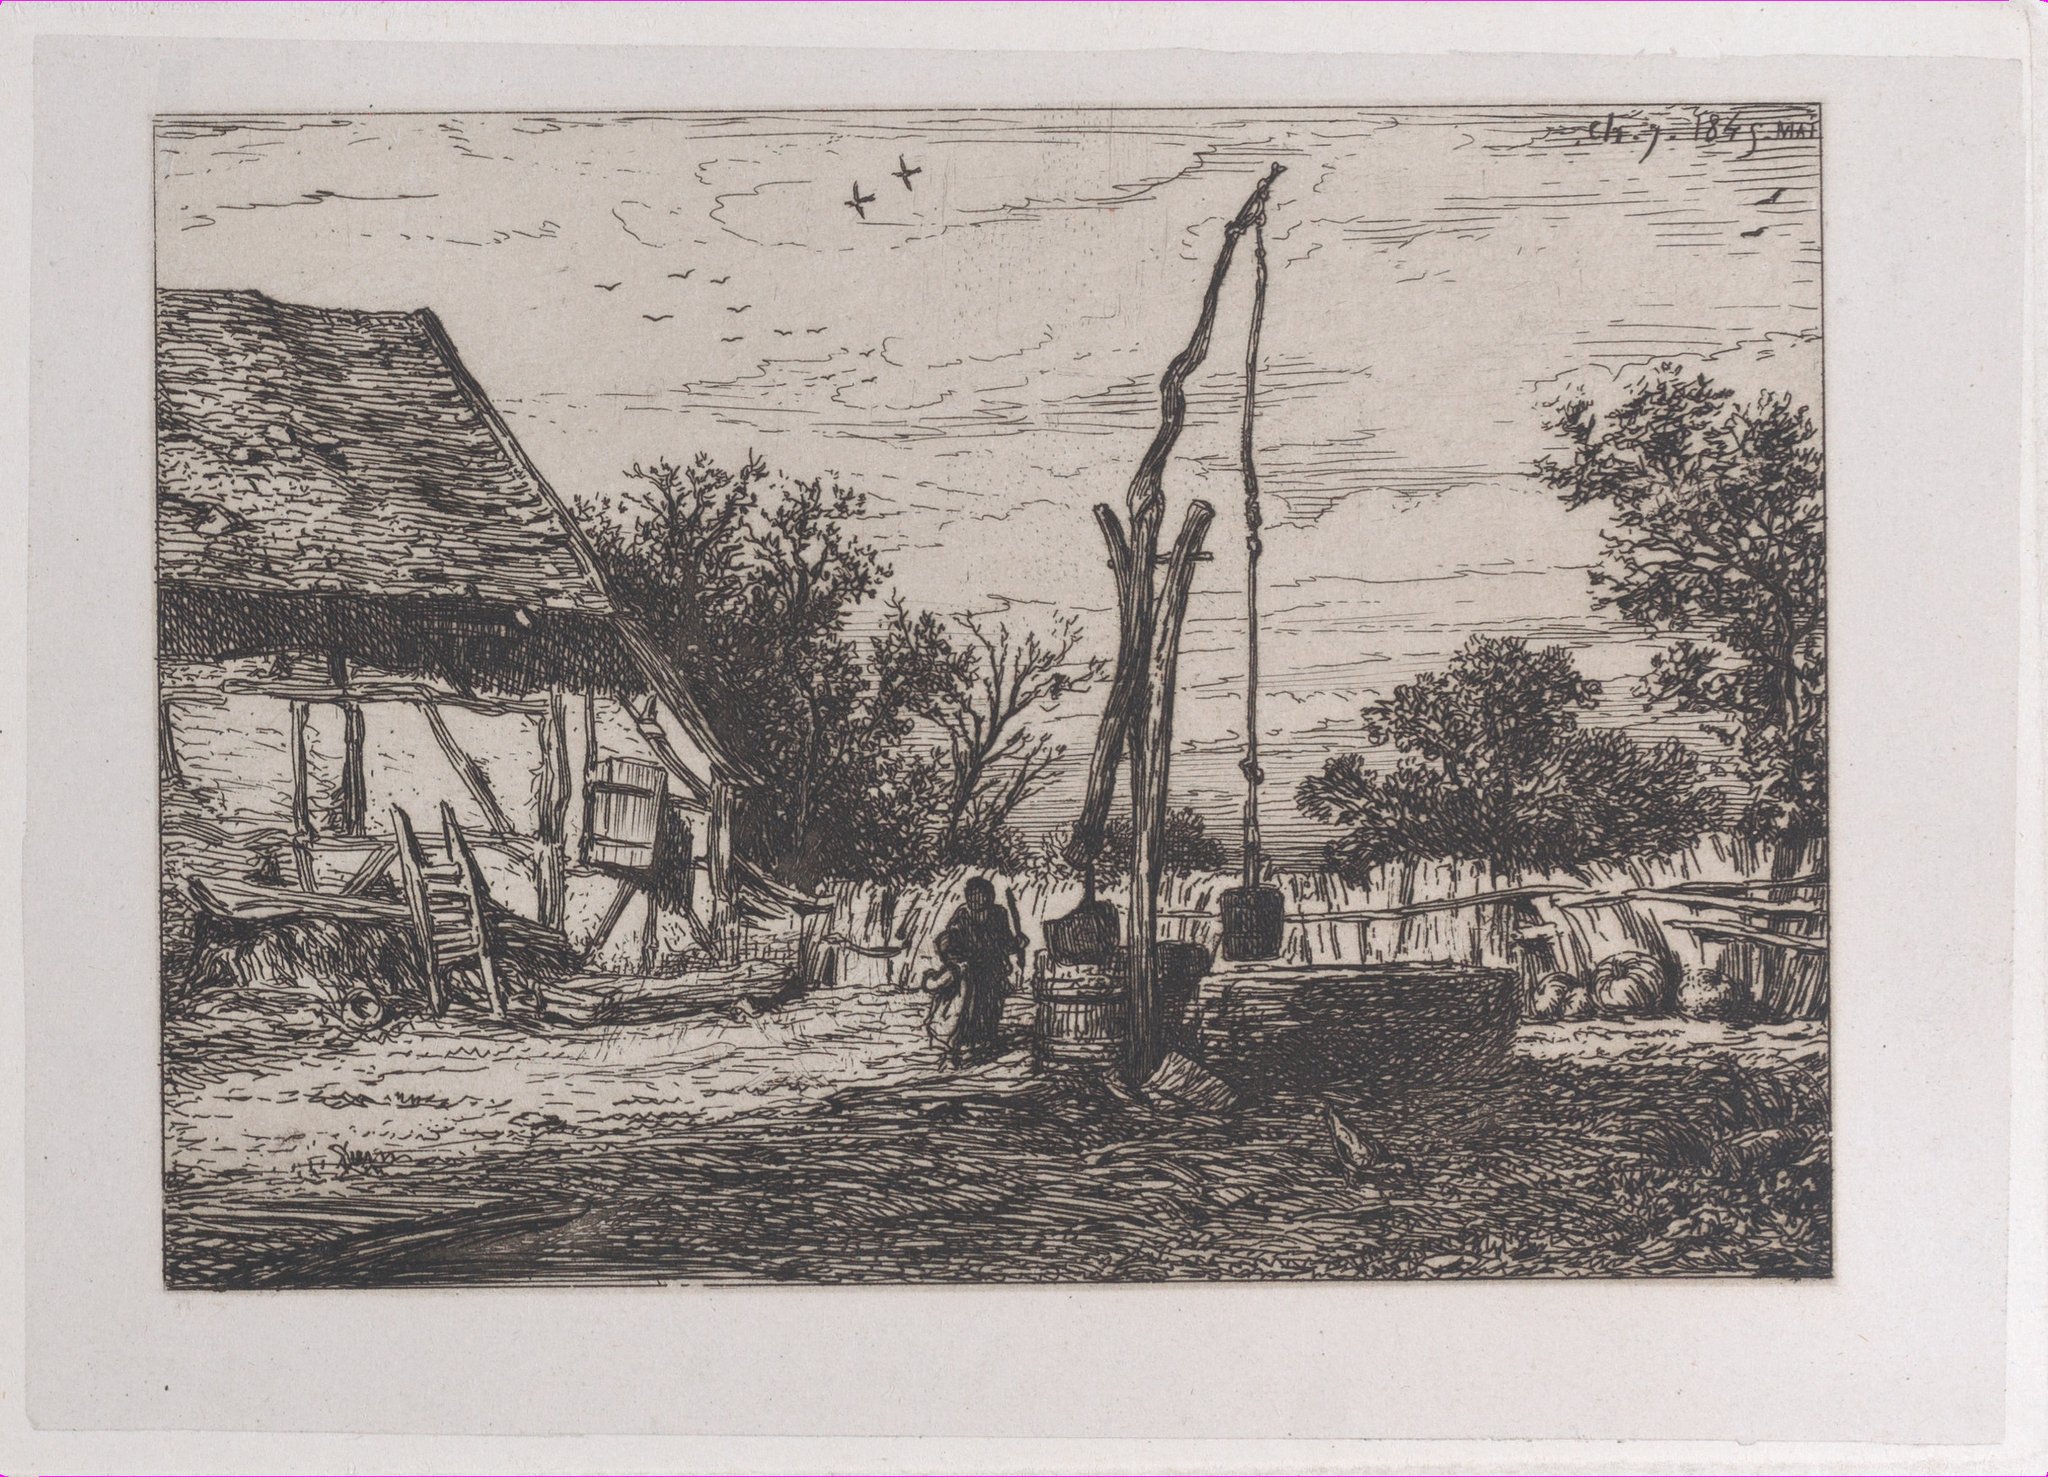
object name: print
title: Landscape with Well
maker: charles émile jacque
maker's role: artist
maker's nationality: french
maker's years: 1813-1894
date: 1845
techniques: etching